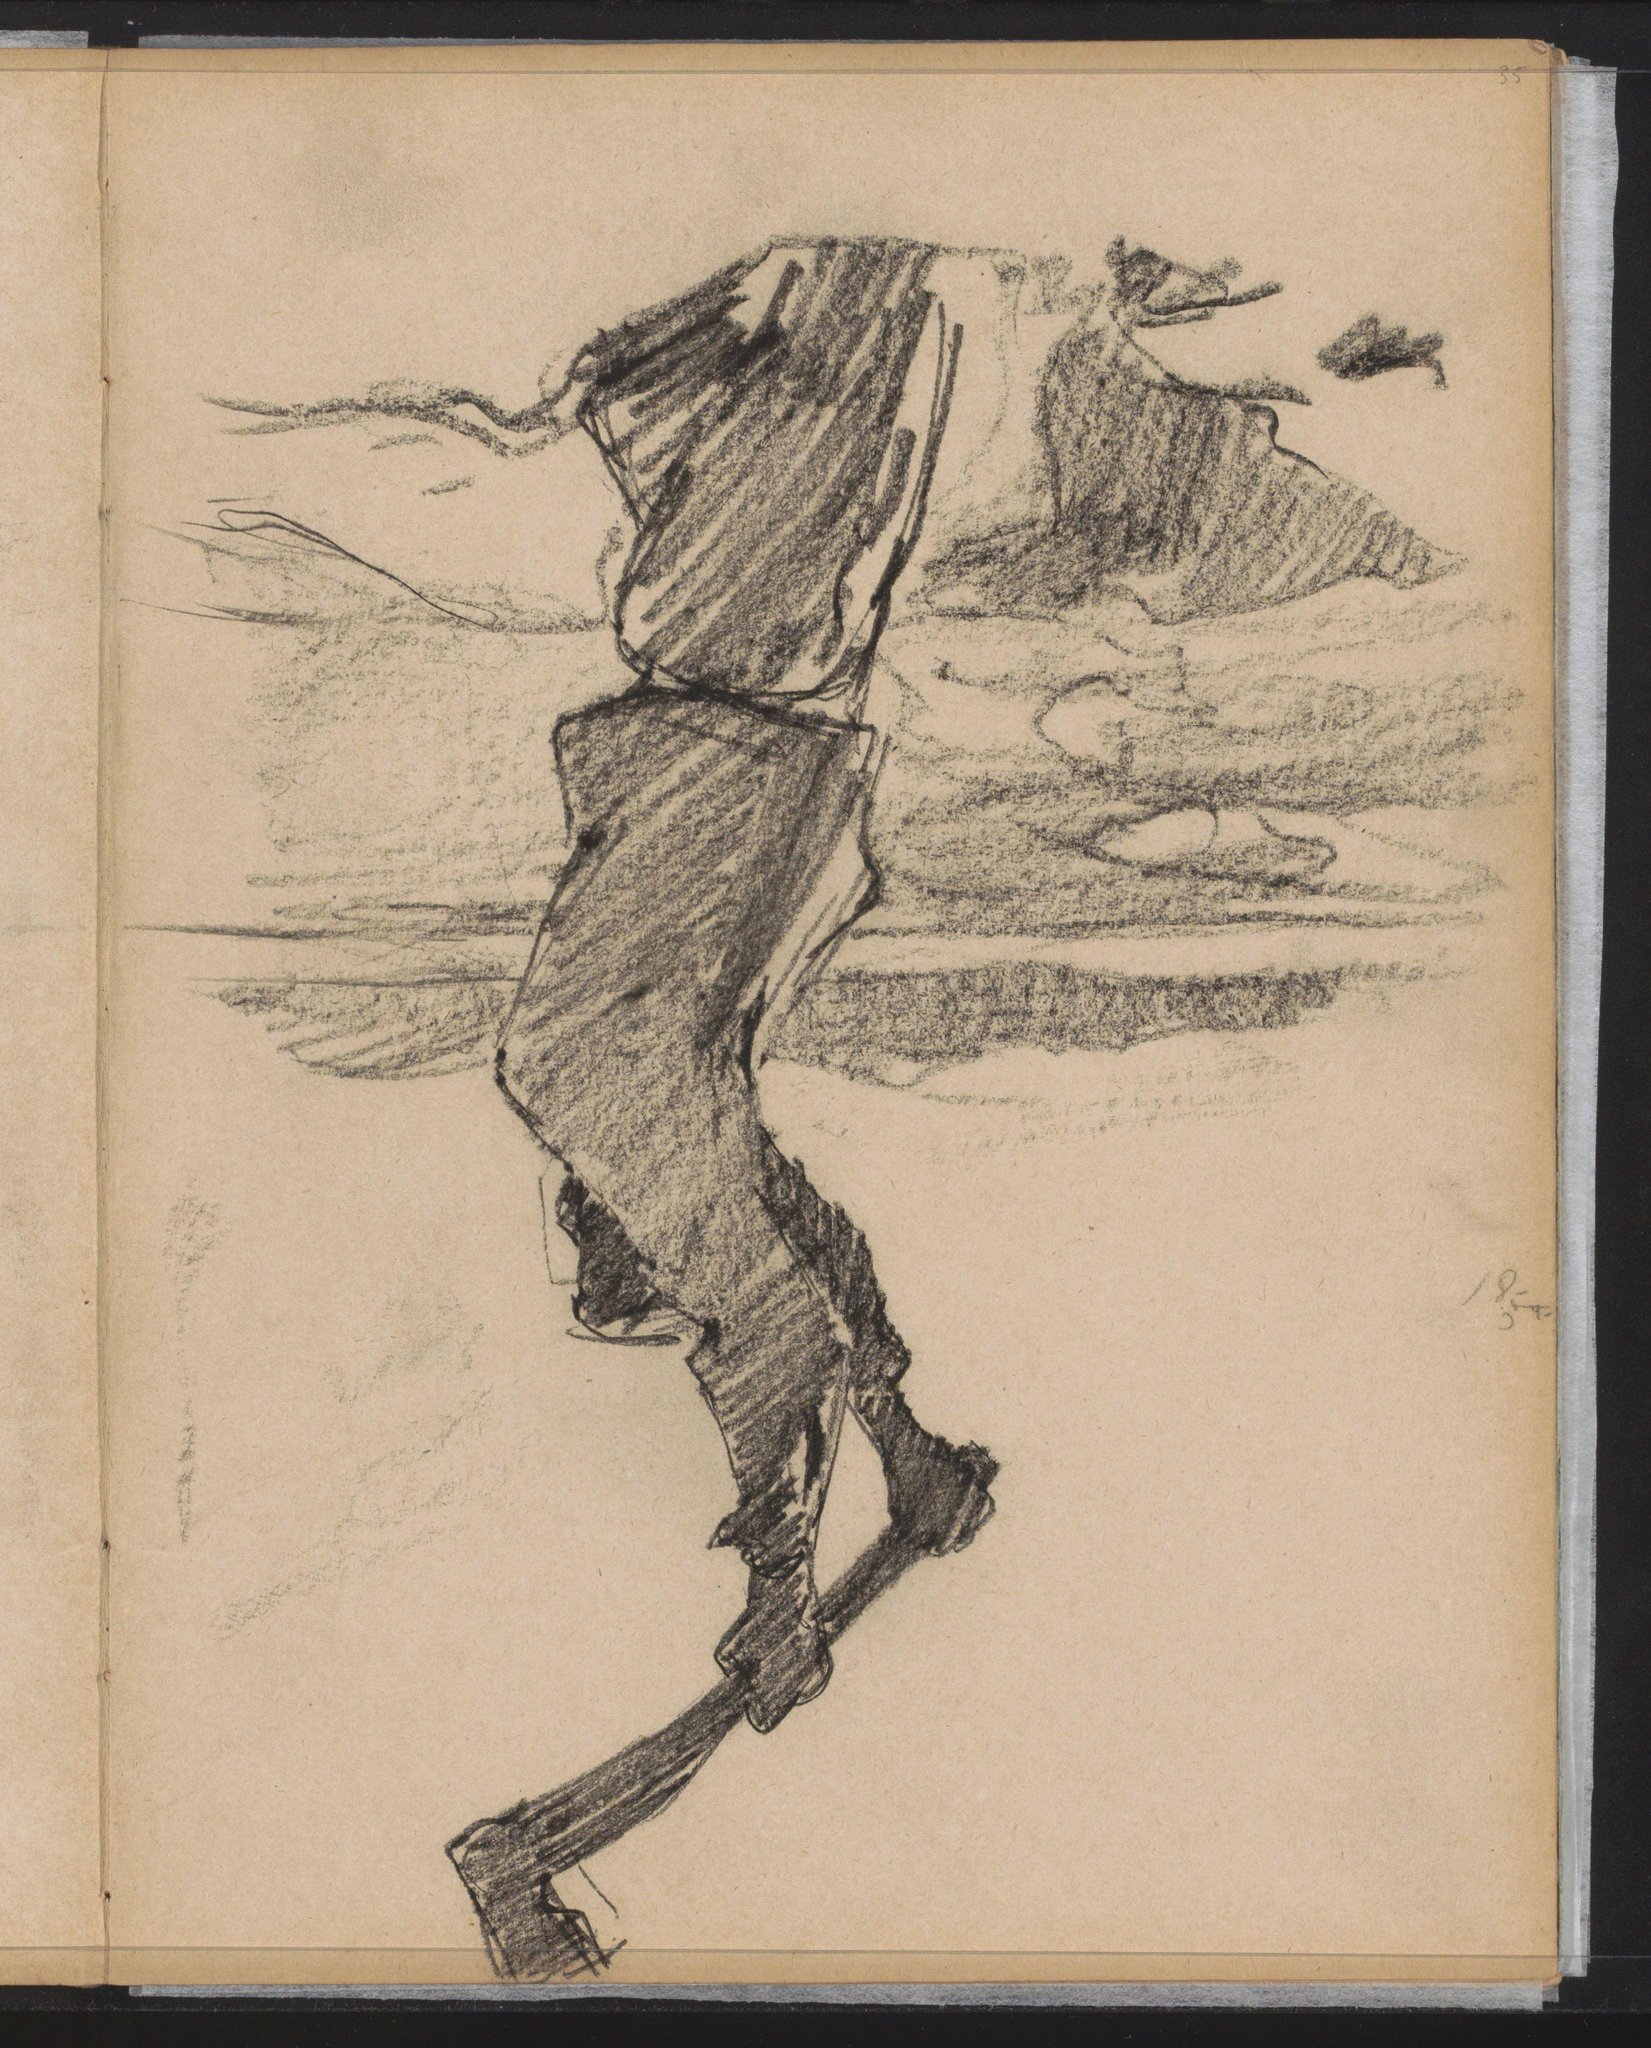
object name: sketchbook leaf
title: Man met opgeheven bijl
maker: willem witsen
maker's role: draughtsman, painter, print maker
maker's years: 1860-1923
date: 1884-1887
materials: chalk, paper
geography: ewijkshoeve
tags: adult man, tools, aids, implements ~ crafts and industries: axe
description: Pagina 35 uit een schetsboek met 49 bladen.